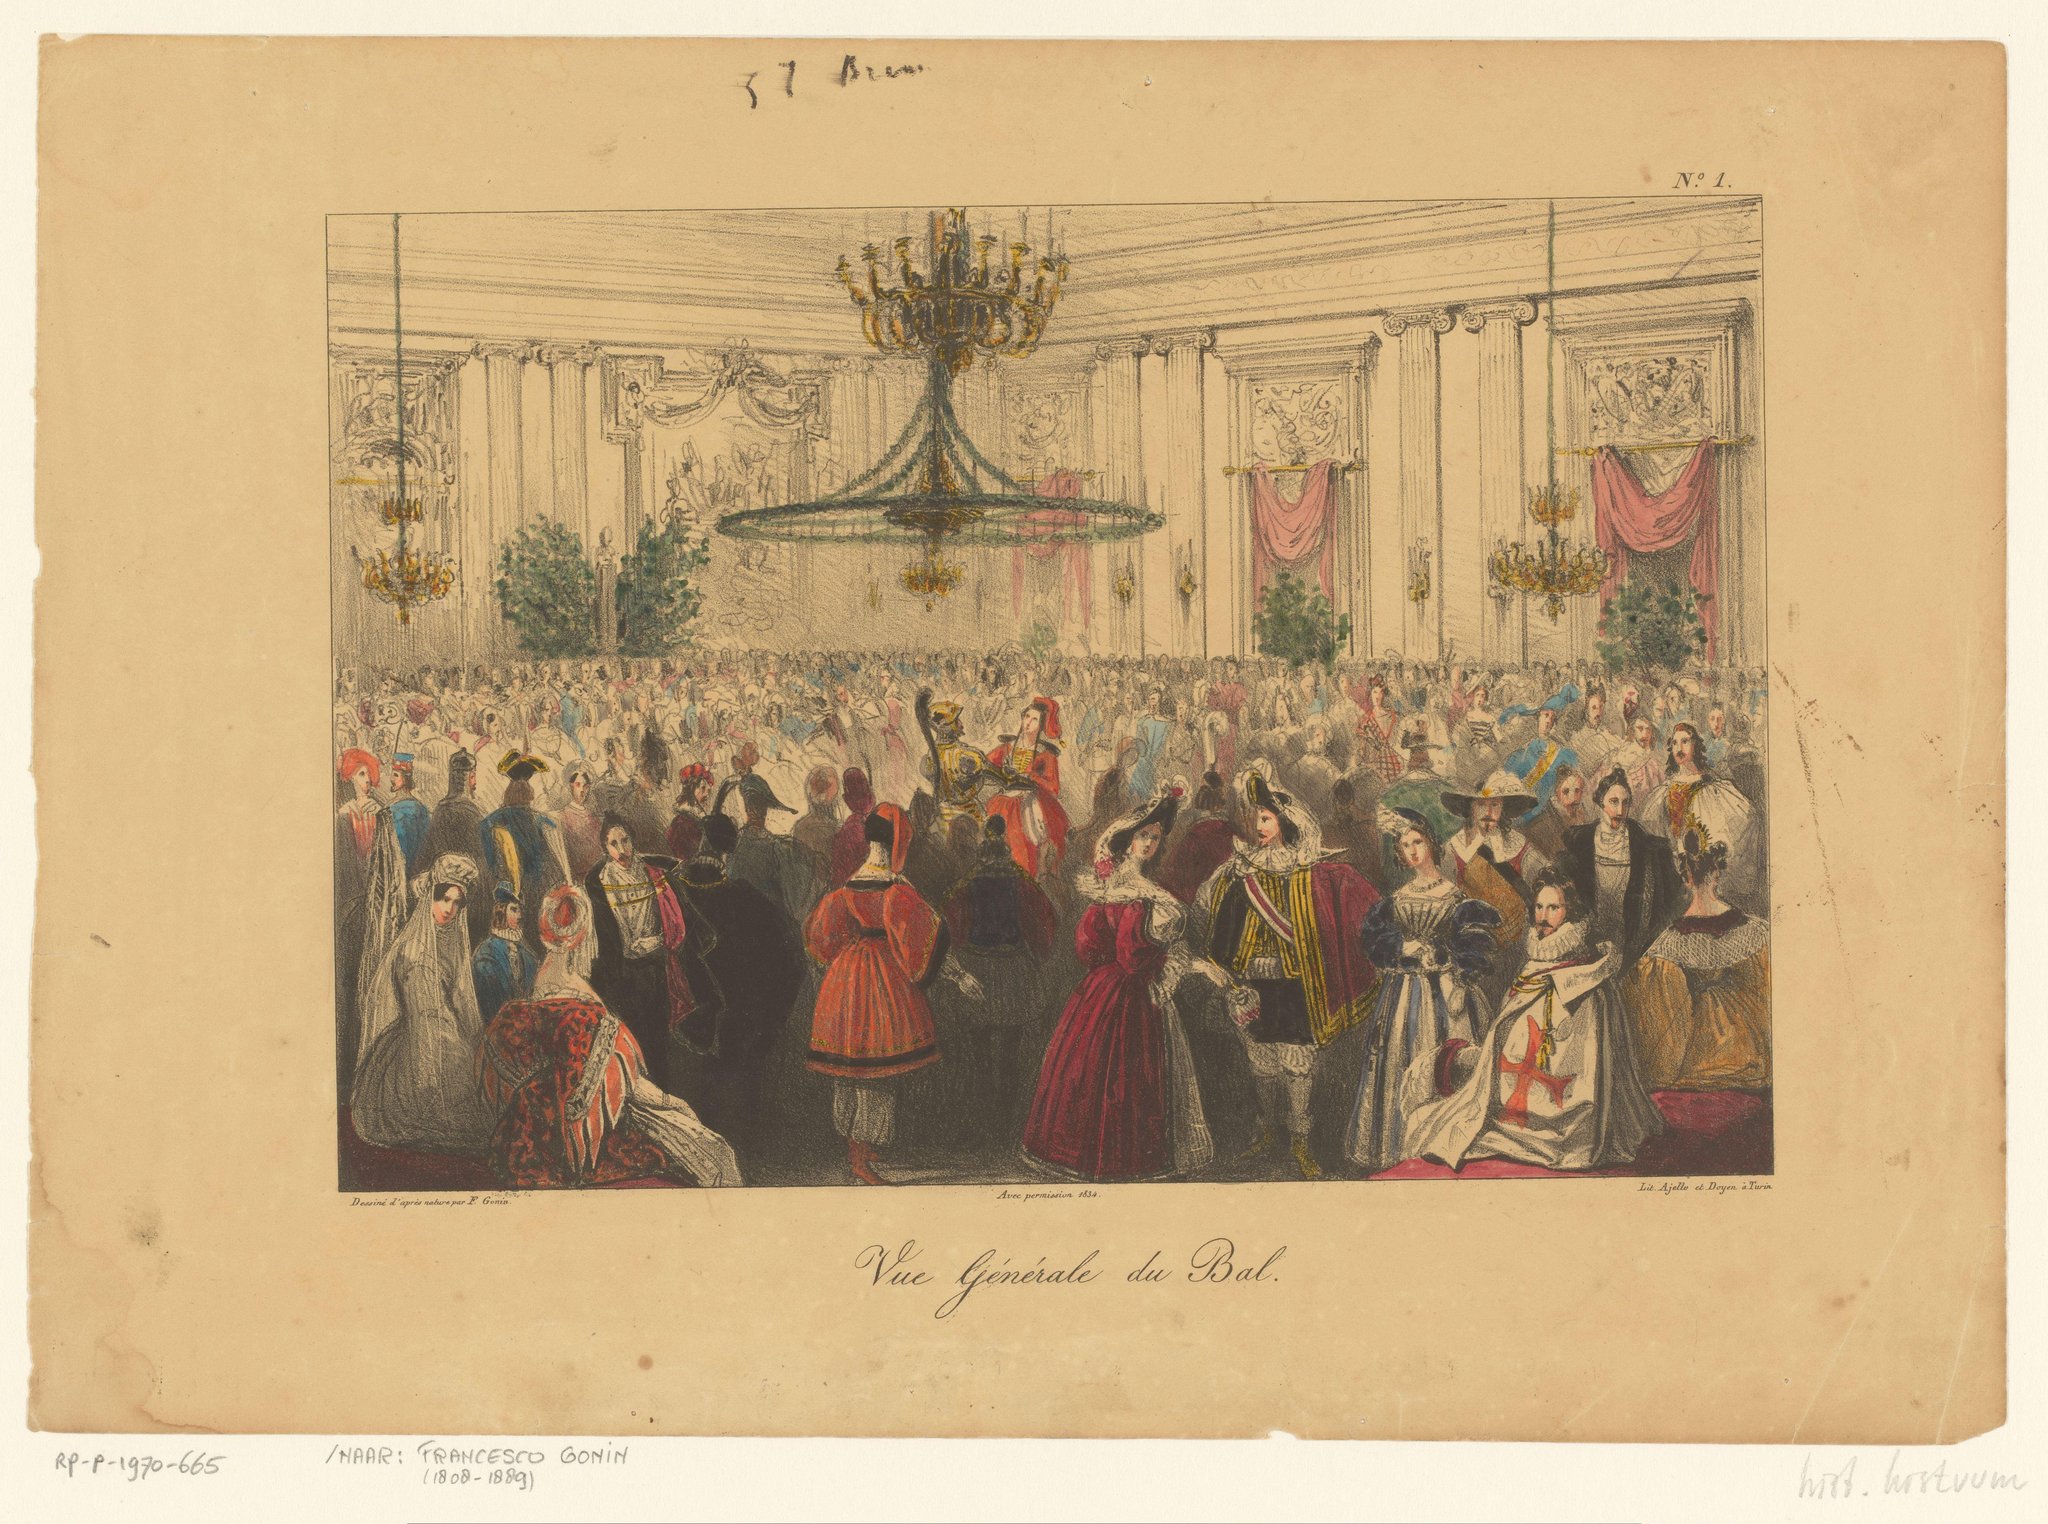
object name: print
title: Gekostumeerd bal, 1834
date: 1834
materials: paper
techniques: hand coloring, lithograph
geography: turin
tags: ball, formal dance(+ costume party ~ festive activities)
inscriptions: collector's mark: Lugt 2228